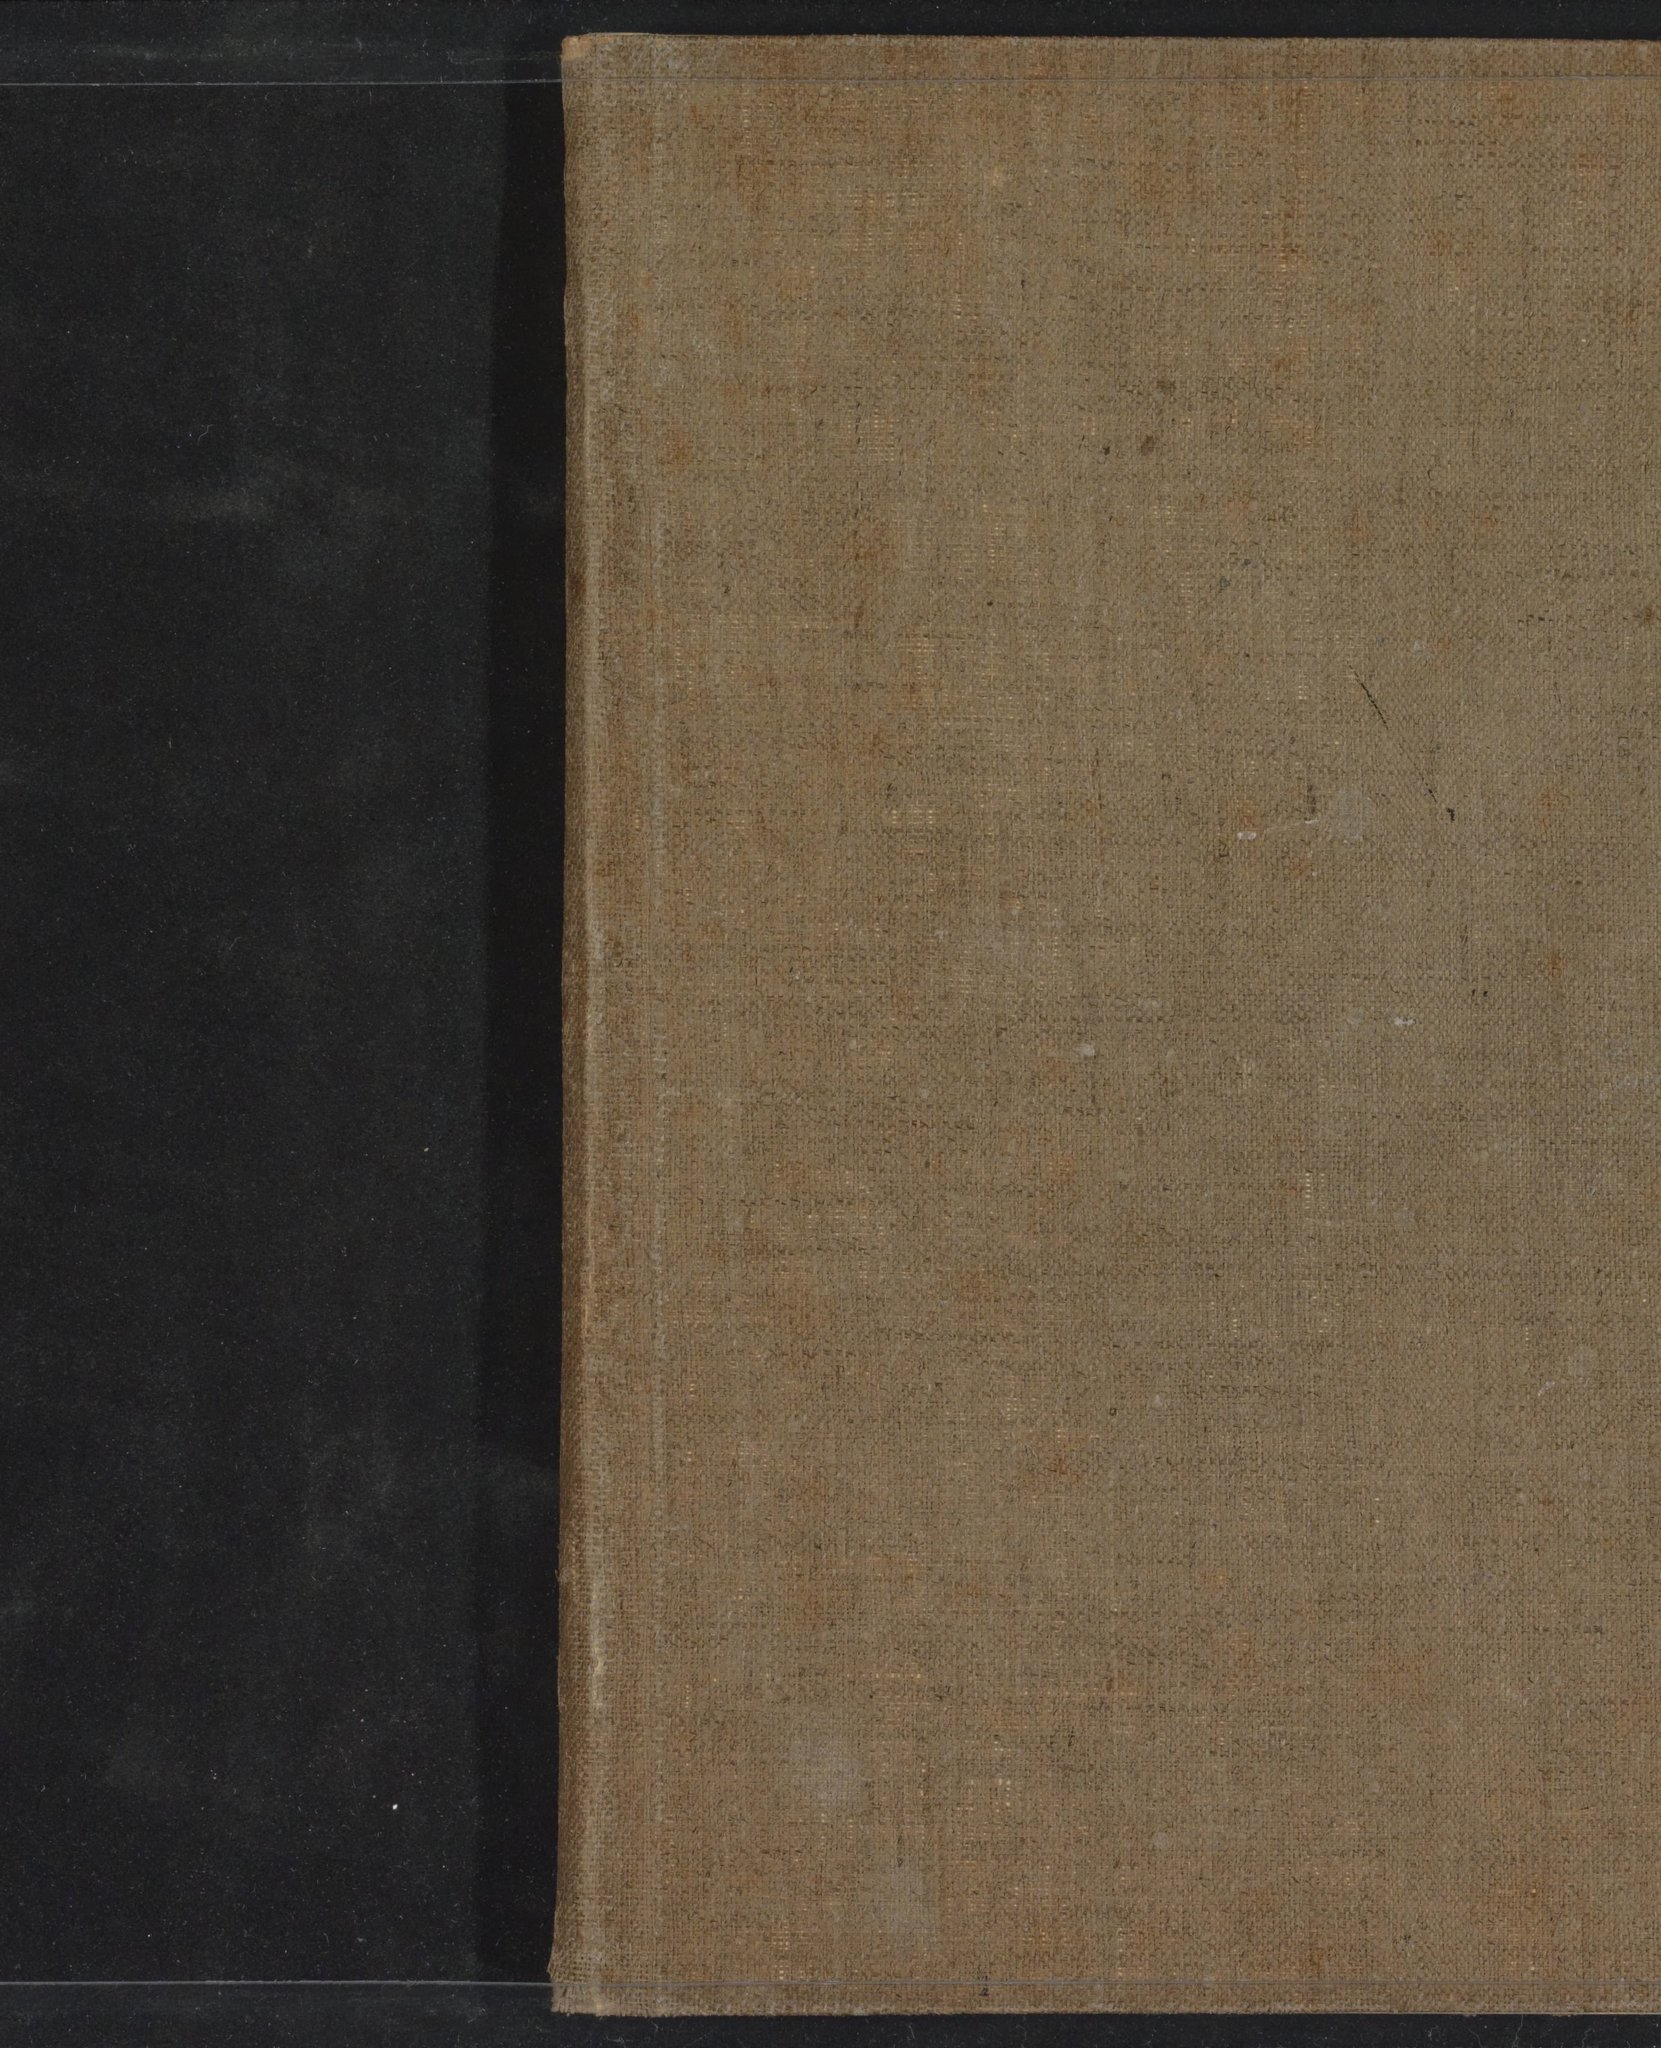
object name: sketchbook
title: Schetsboek met 28 bladen en 3 losse tekeningen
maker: otto verhagen (i)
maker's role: draughtsman, print maker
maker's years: 1885-1951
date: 1917-1919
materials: cardboard, chalk, charcoal, ink, linen, paper, pencil, watercolor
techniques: brush, pen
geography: winschoten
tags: caricatures (human types), female sex; woman, child, male sex; man, maarssen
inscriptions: factory mark: ‘SKETCHER'S/ NOTE BOOK/ SERIES A 42./ containing 80 leaves of good white paper,/ MANUFACTURED BY/ GEO. ROWNEY & Co., LONDON, W., ENGLAND./ SIZE No. 3-11 x 8 1/2 inches/ Dimensions de l'album 28 x 21 cm.’, inscription: ‘IA’, collector's mark: Lugt 2228a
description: Schetsboek bestaande uit 28 bladen en 3 losse tekeningen met voornamelijk figuurstudies en karikaturen, onder andere van mensen uit Winschoten, en scènes uit het dagelijks leven. Mogelijk voorstudies voor boekillustraties.